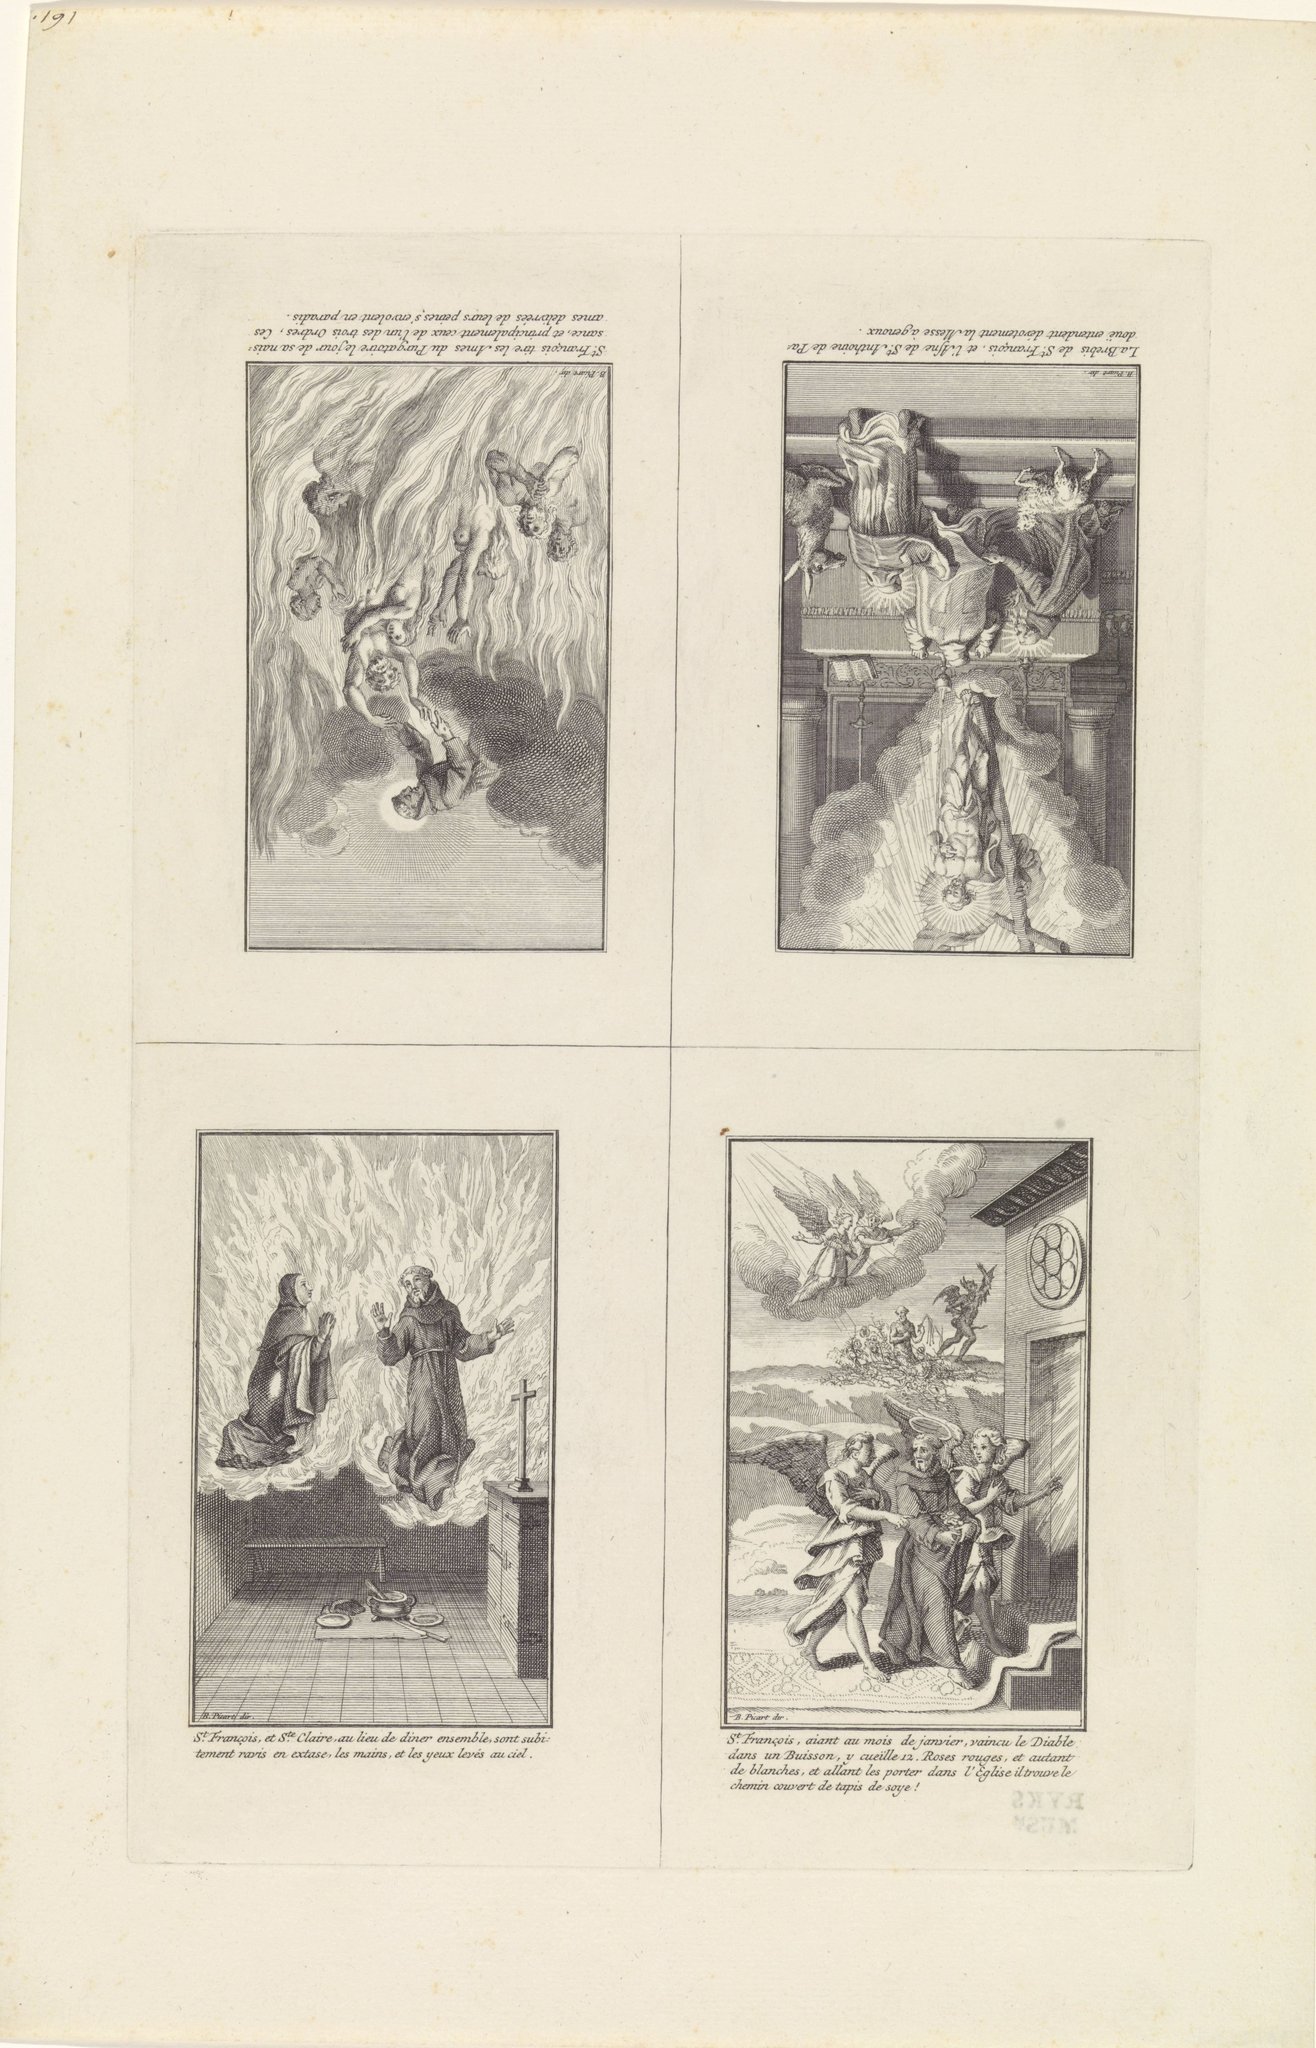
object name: book illustration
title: Scènes uit het leven van Heilige Franciscus van Assisi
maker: bernard picart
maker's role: draughtsman, print maker, publisher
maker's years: 1673-1733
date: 1734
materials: paper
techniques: engraving, etching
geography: amsterdam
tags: st. clare and st. francis of assisi, founder of the order of friars minor (franciscans), francis(cus) of assisi; possible attributes: book, crucifix, lily, skull, stigmata, appearances of st. francis of assisi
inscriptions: number: ‘161.’, collector's mark: Lugt 2165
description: Blad met vier boekillustraties die scènes uit het leven van de H. Franciscus van Assisi verbeelden. Respectievelijk: Franciscus redt zielen uit het vagevuur, Franciscus van Assisi (met lam) en Antonius van Padua (met ezel) flankeren een priester die voor een altaar knielt waar Christus verschijnt, Clara en Franciscus, twee engelen begeleiden Franciscus naar de ingang van de kerk; op de achtergrond overwint hij de duivel.